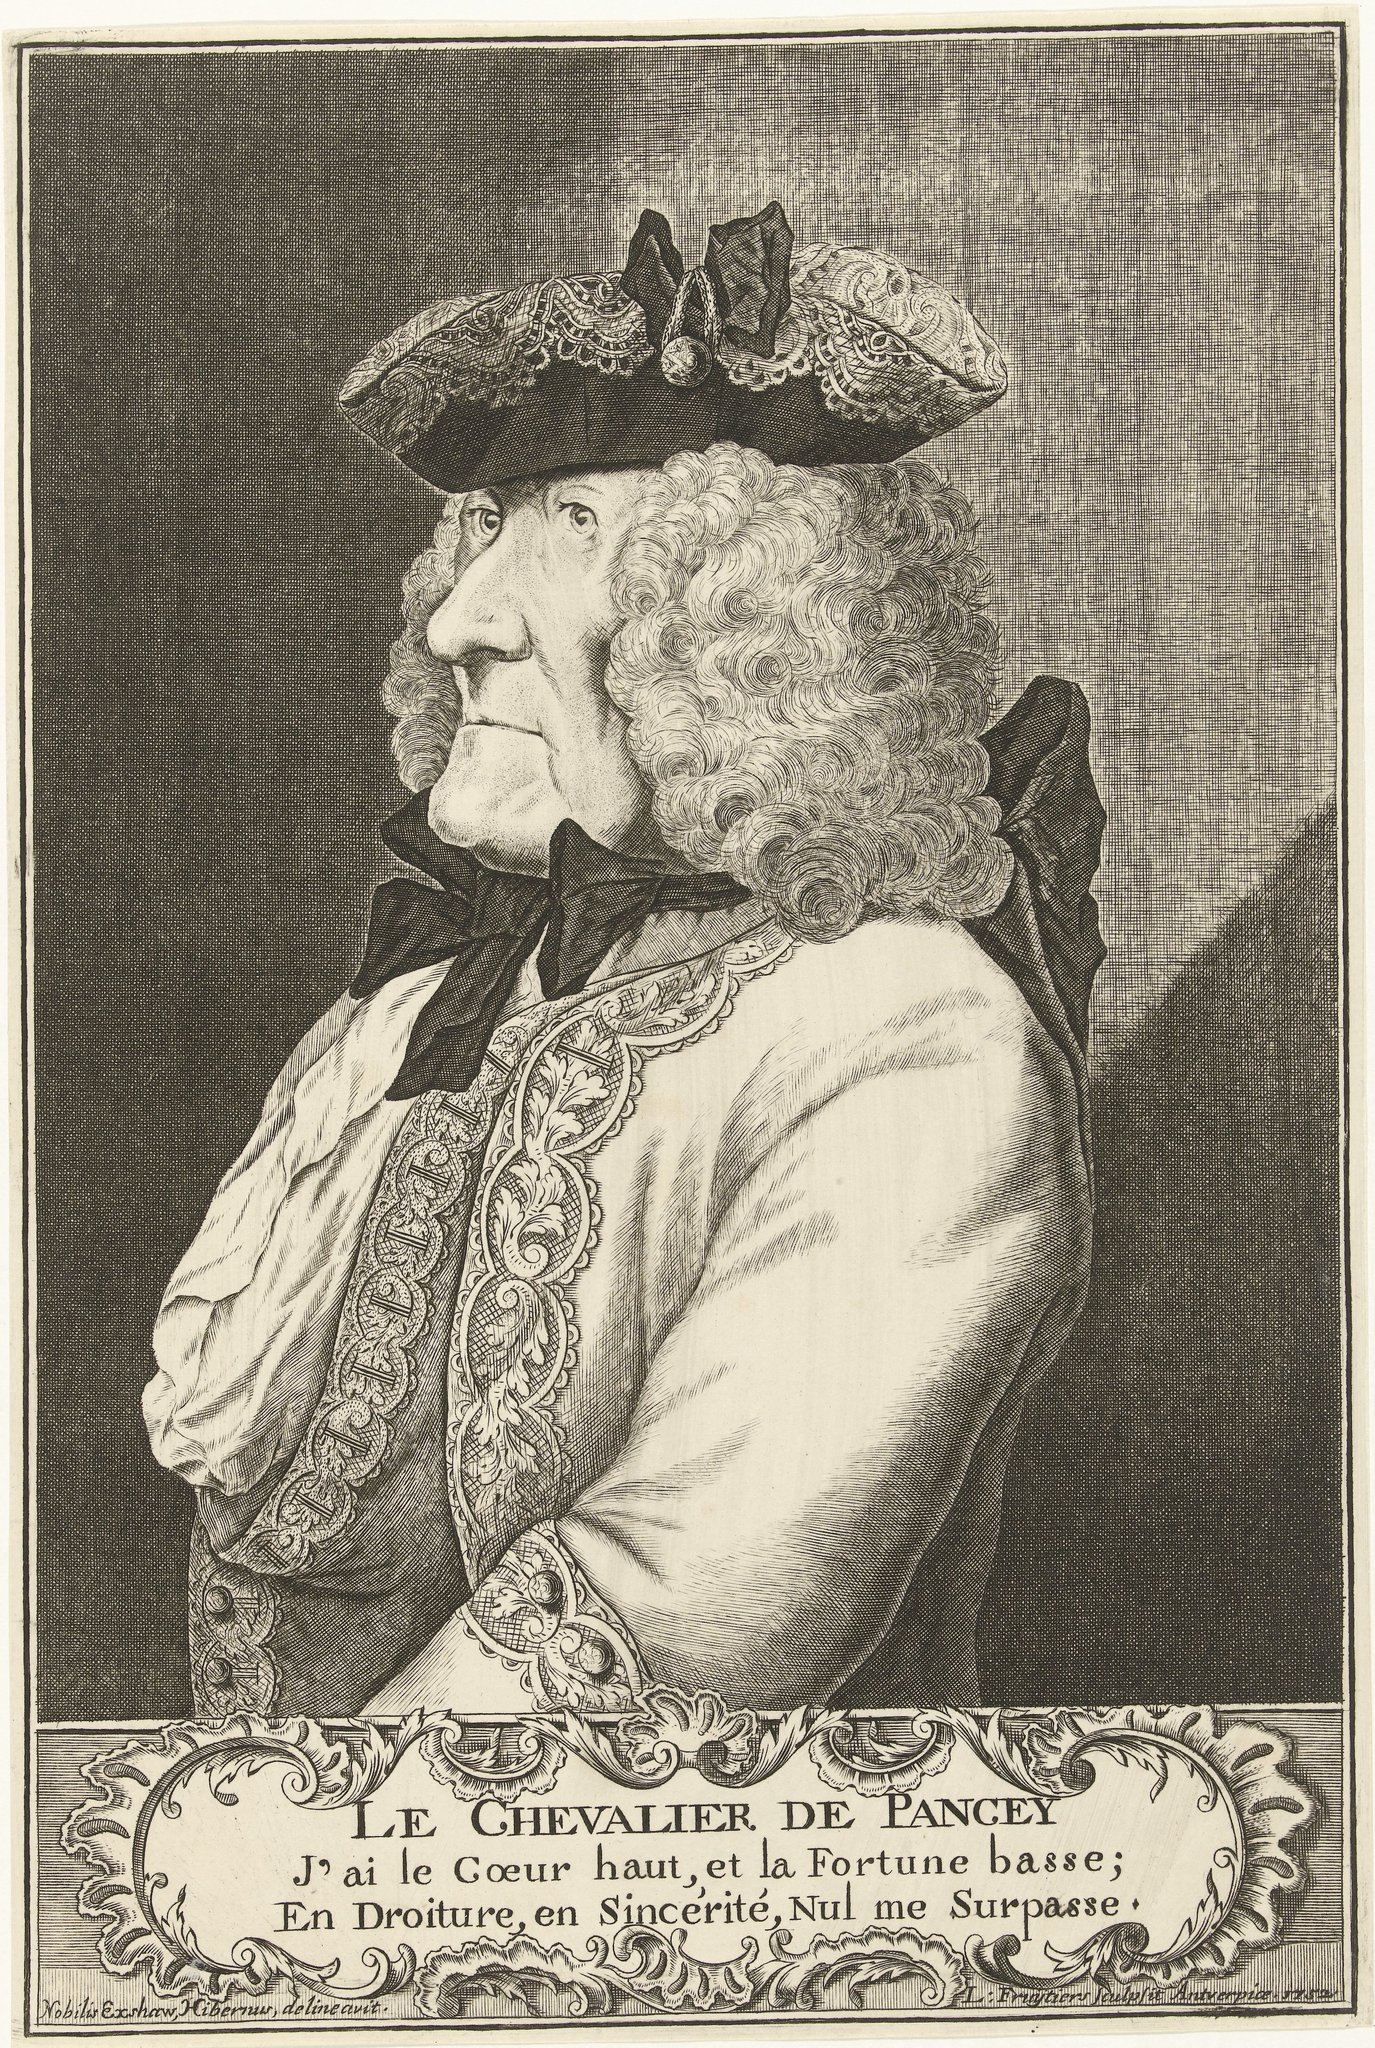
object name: print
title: Portret van de ridder van Pancey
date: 1752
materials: paper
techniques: engraving, etching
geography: antwerp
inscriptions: collector's mark: Lugt 2228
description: Portretbuste naar links van de ridder van Pancey, met hoed. Onder het portret staan in een cartouche de naam van de geportretteerde en een tweeregelige tekst in het Frans.